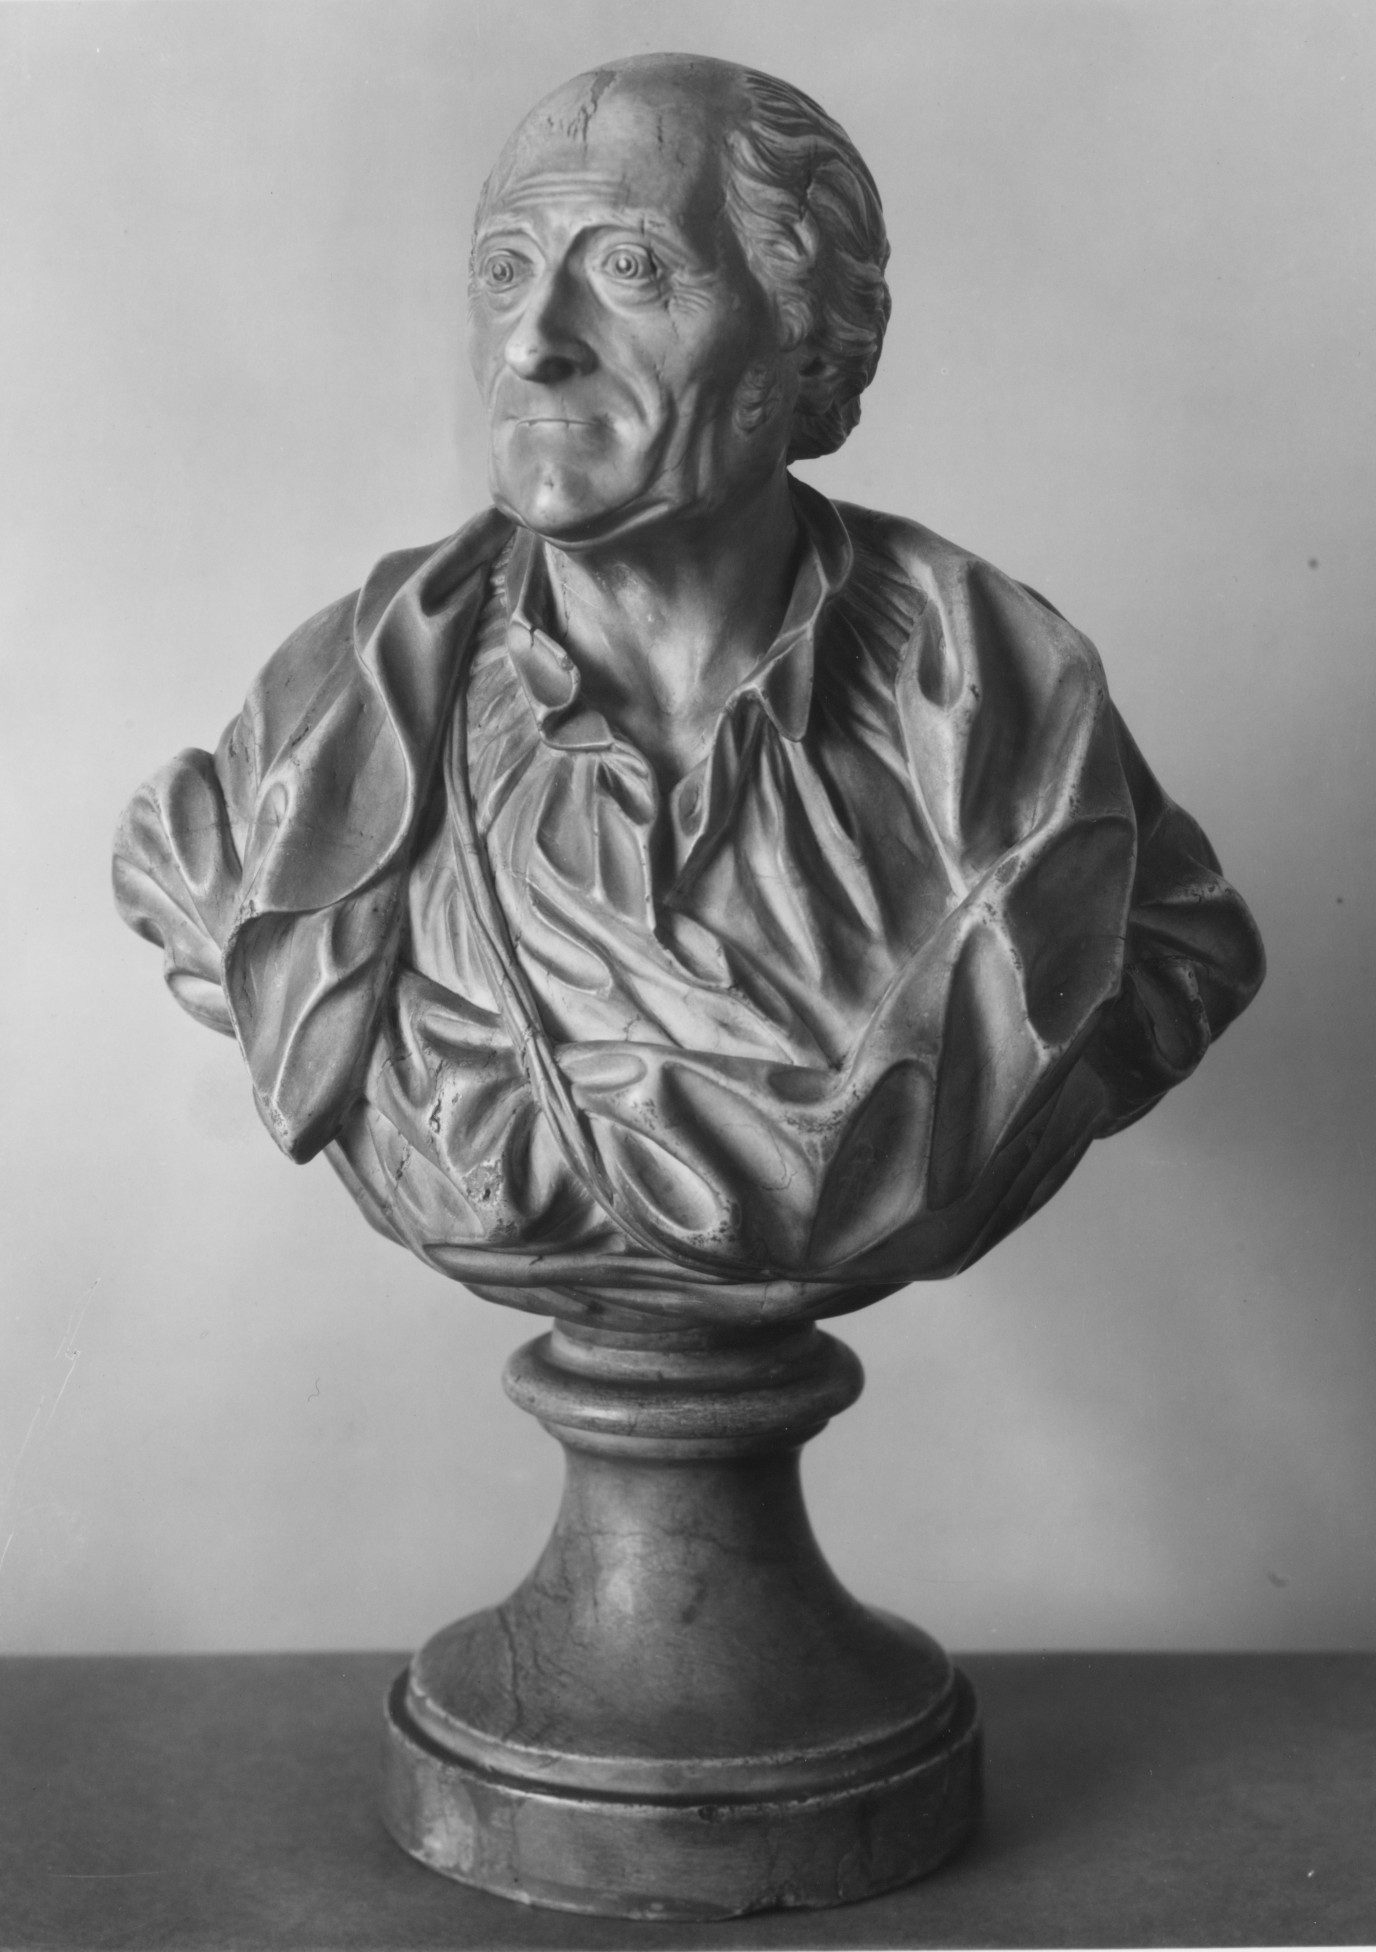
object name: bust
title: Voltaire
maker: jean-claude-françois-joseph rosset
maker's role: artist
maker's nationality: french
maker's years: 1706-1786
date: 1750-1786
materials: marble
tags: men